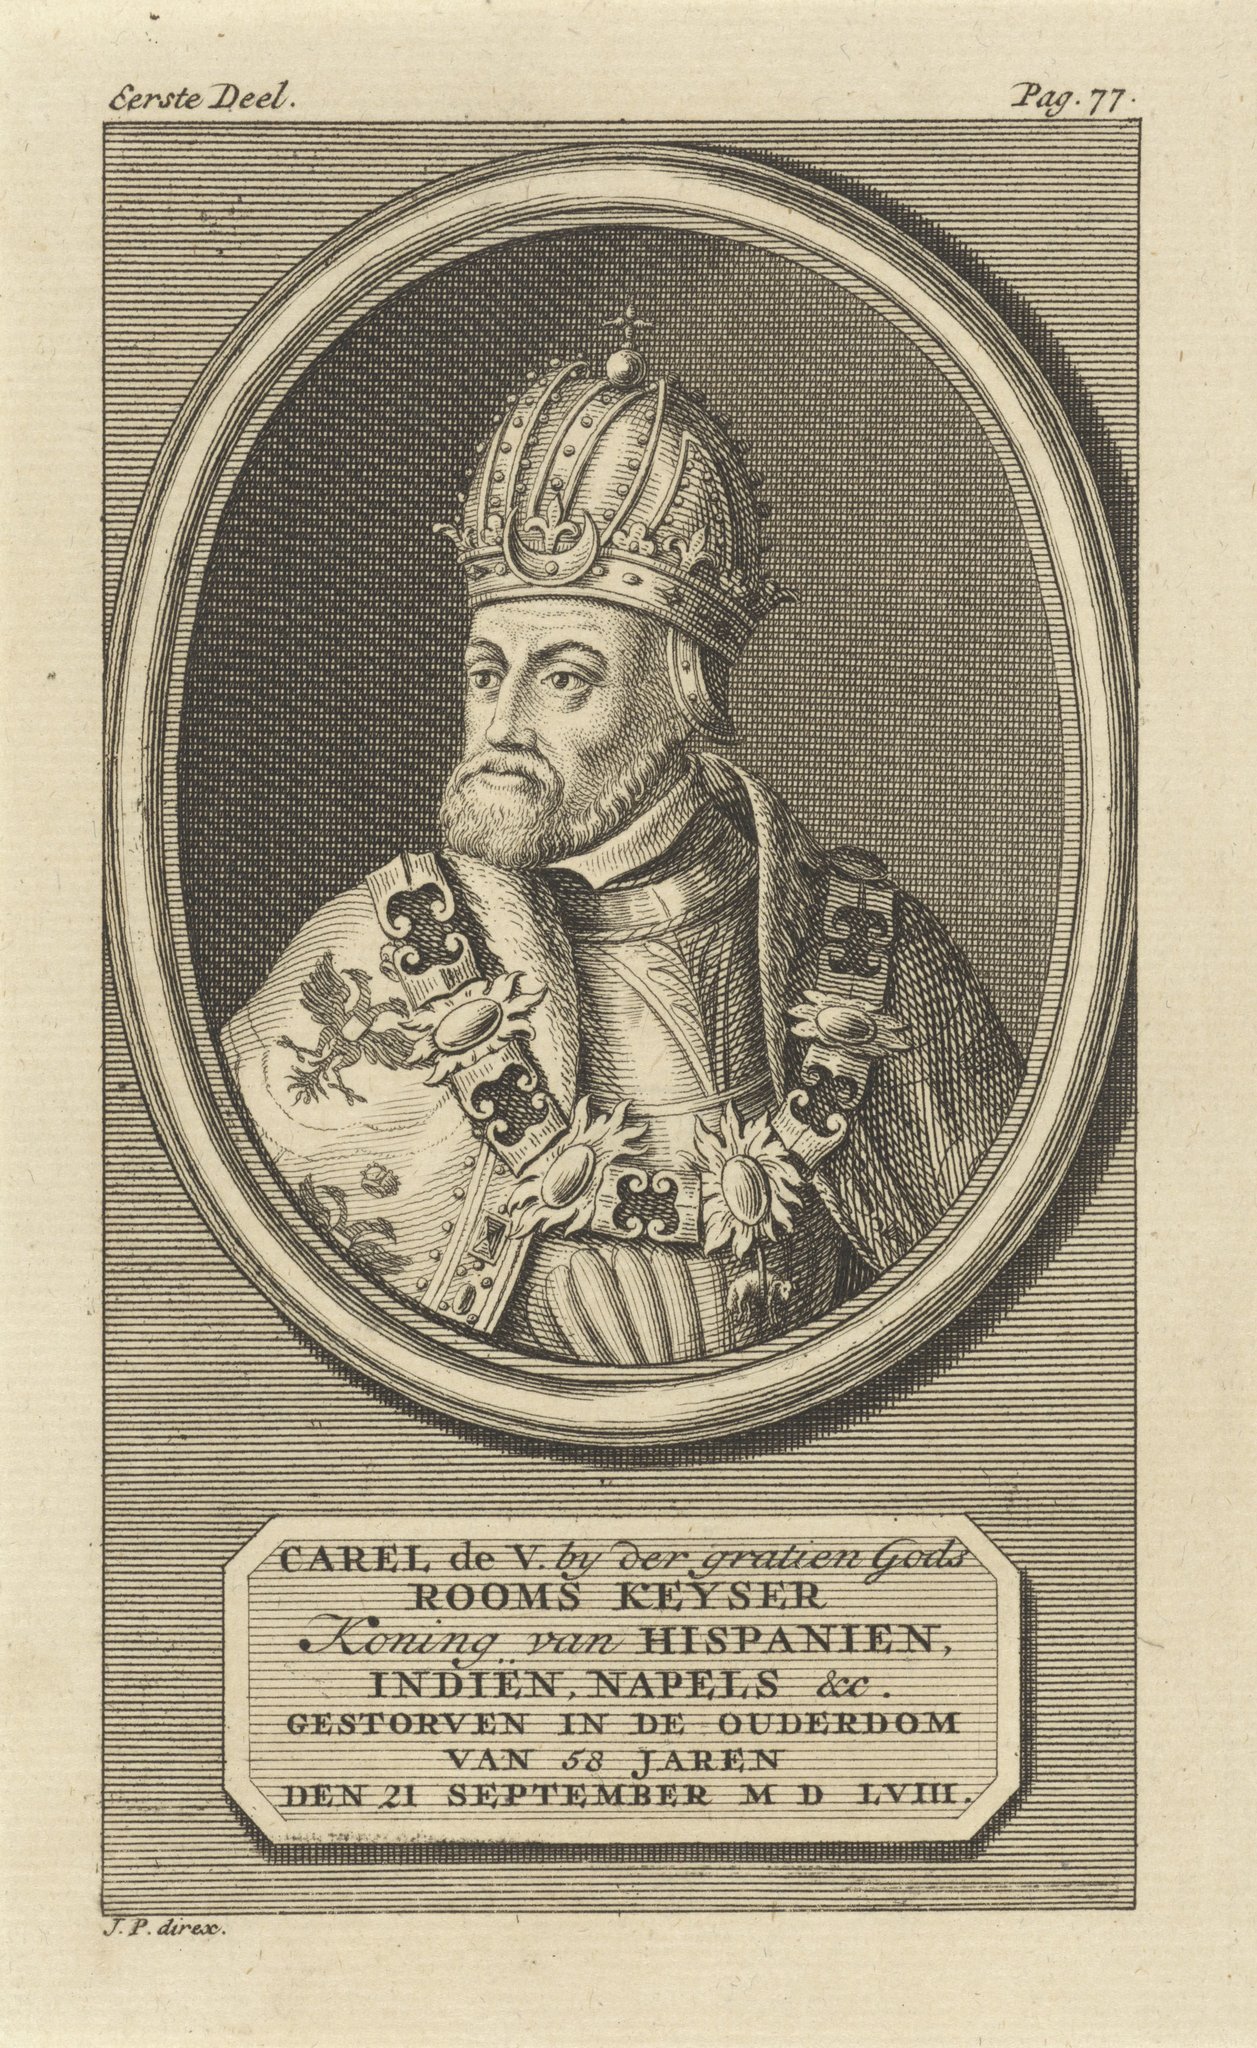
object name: book illustration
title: Portret van keizer Karel V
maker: jan punt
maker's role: draughtsman, print maker, publisher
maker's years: 1711-1779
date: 1748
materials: paper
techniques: engraving, etching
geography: northern netherlands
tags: ghent, charles v (holy roman emperor and king of spain), knighthood order of the golden fleece, emperor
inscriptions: collector's mark: Lugt 2228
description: Illustratie uit: Meteren, Emanuel van. Historie van de oorlogen en geschiedenissen der Nederlanderen, en der zelver naburen: beginnende met den jare 1315, en eindigende met den jare 1611, deel I, p. 77. Gorinchem/Breda: Nicolaas Goetzee, Pieter Goetzee/Willem Goetzee, 1748.